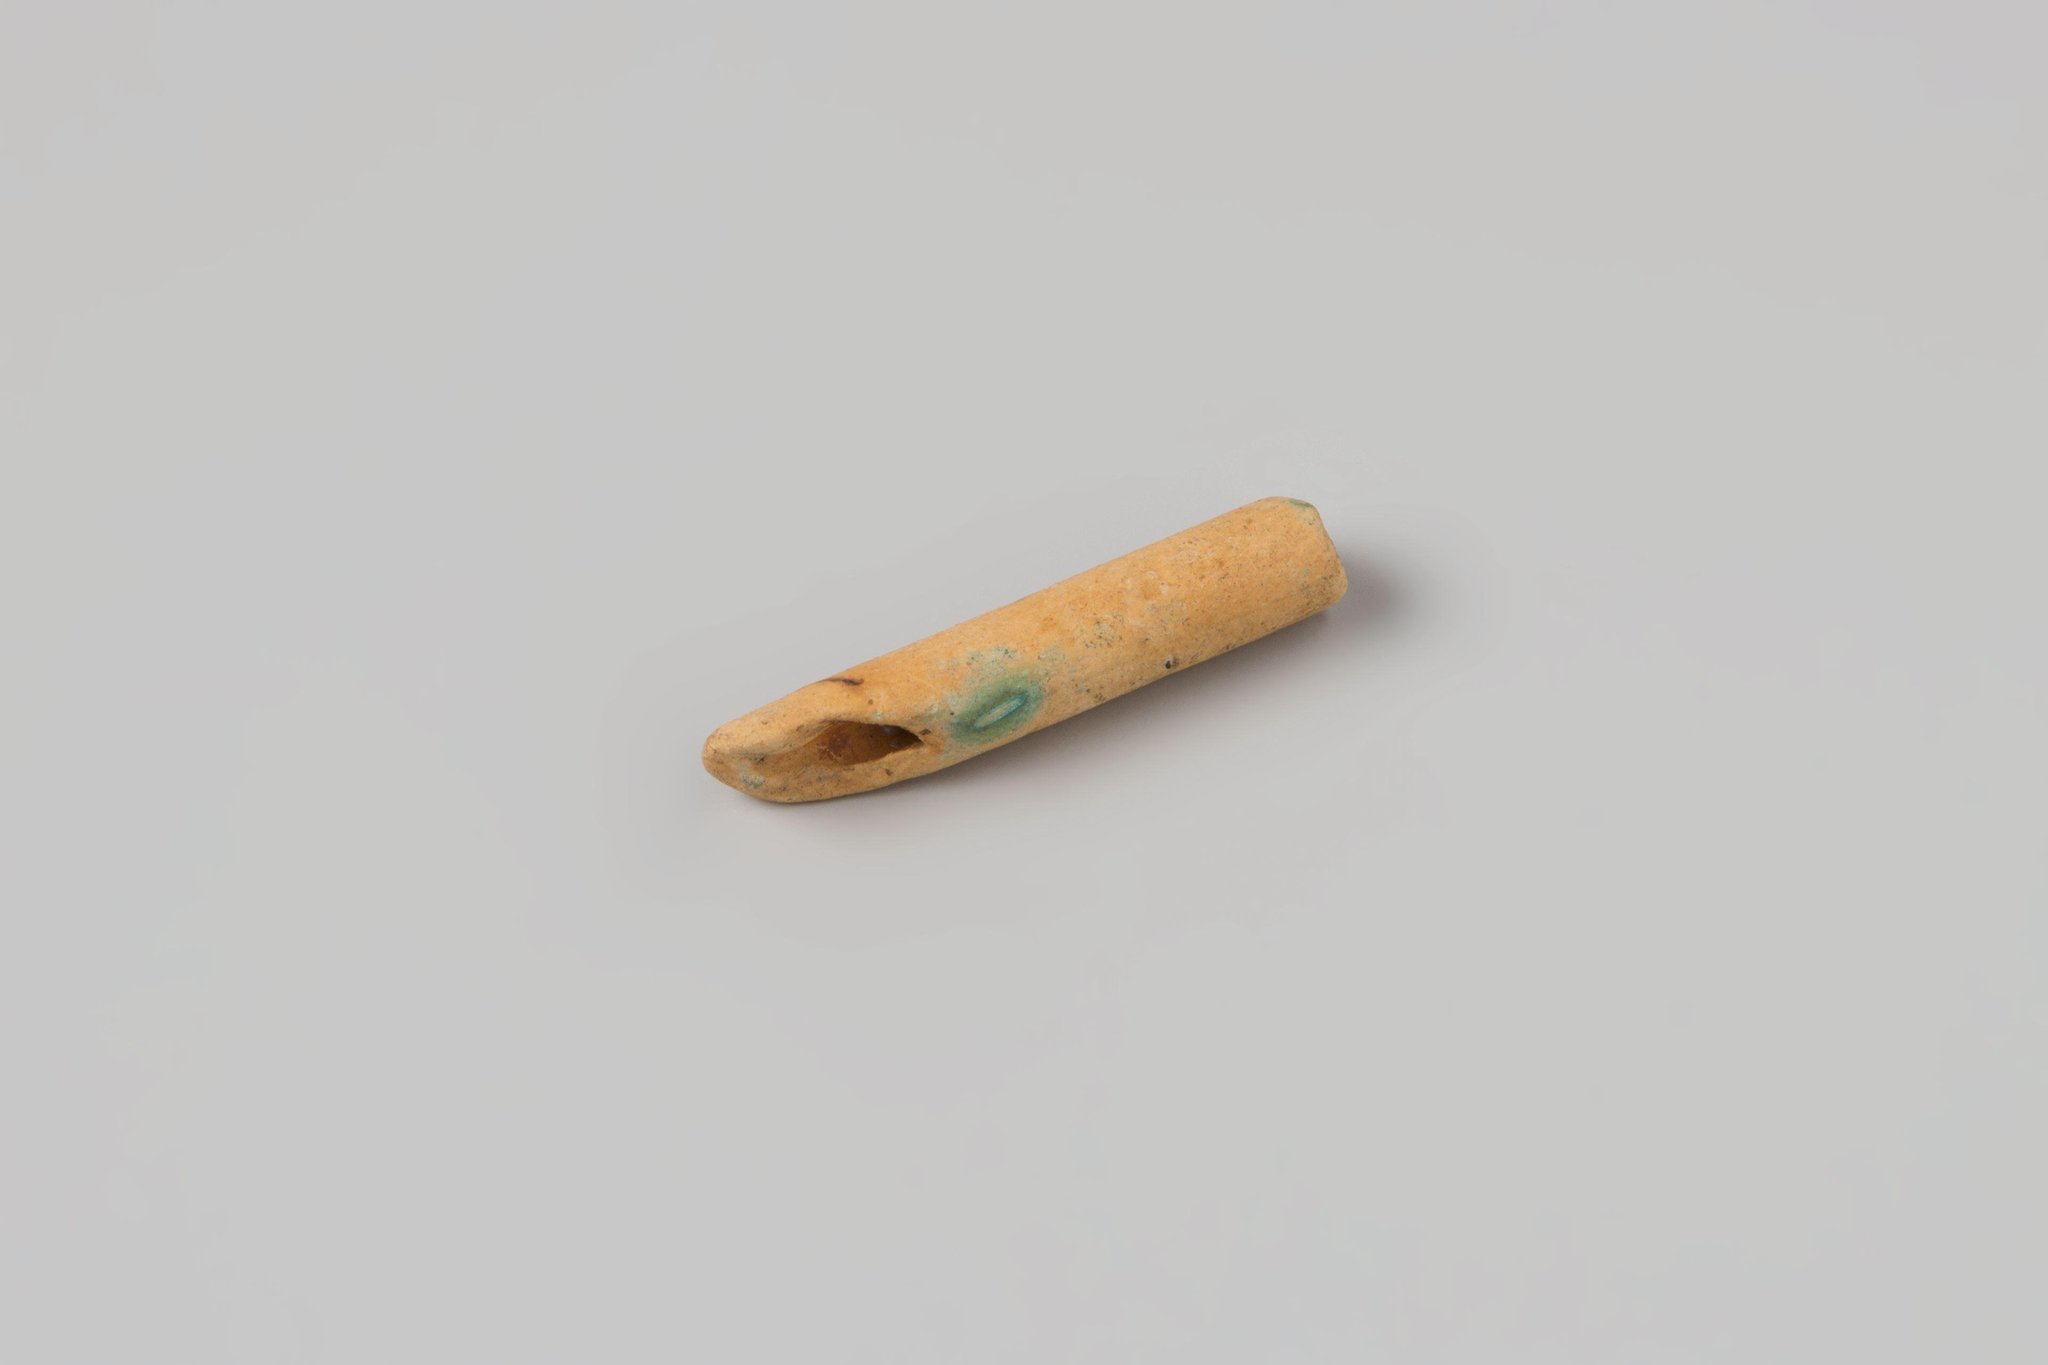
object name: pipe stem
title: Fragment pijpensteel uit het wrak van de Oost-Indiëvaarder Hollandia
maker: Anonymous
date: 1700-1743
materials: clay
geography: netherlands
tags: verenigde oostindische compagnie, hollandia (schip), annet